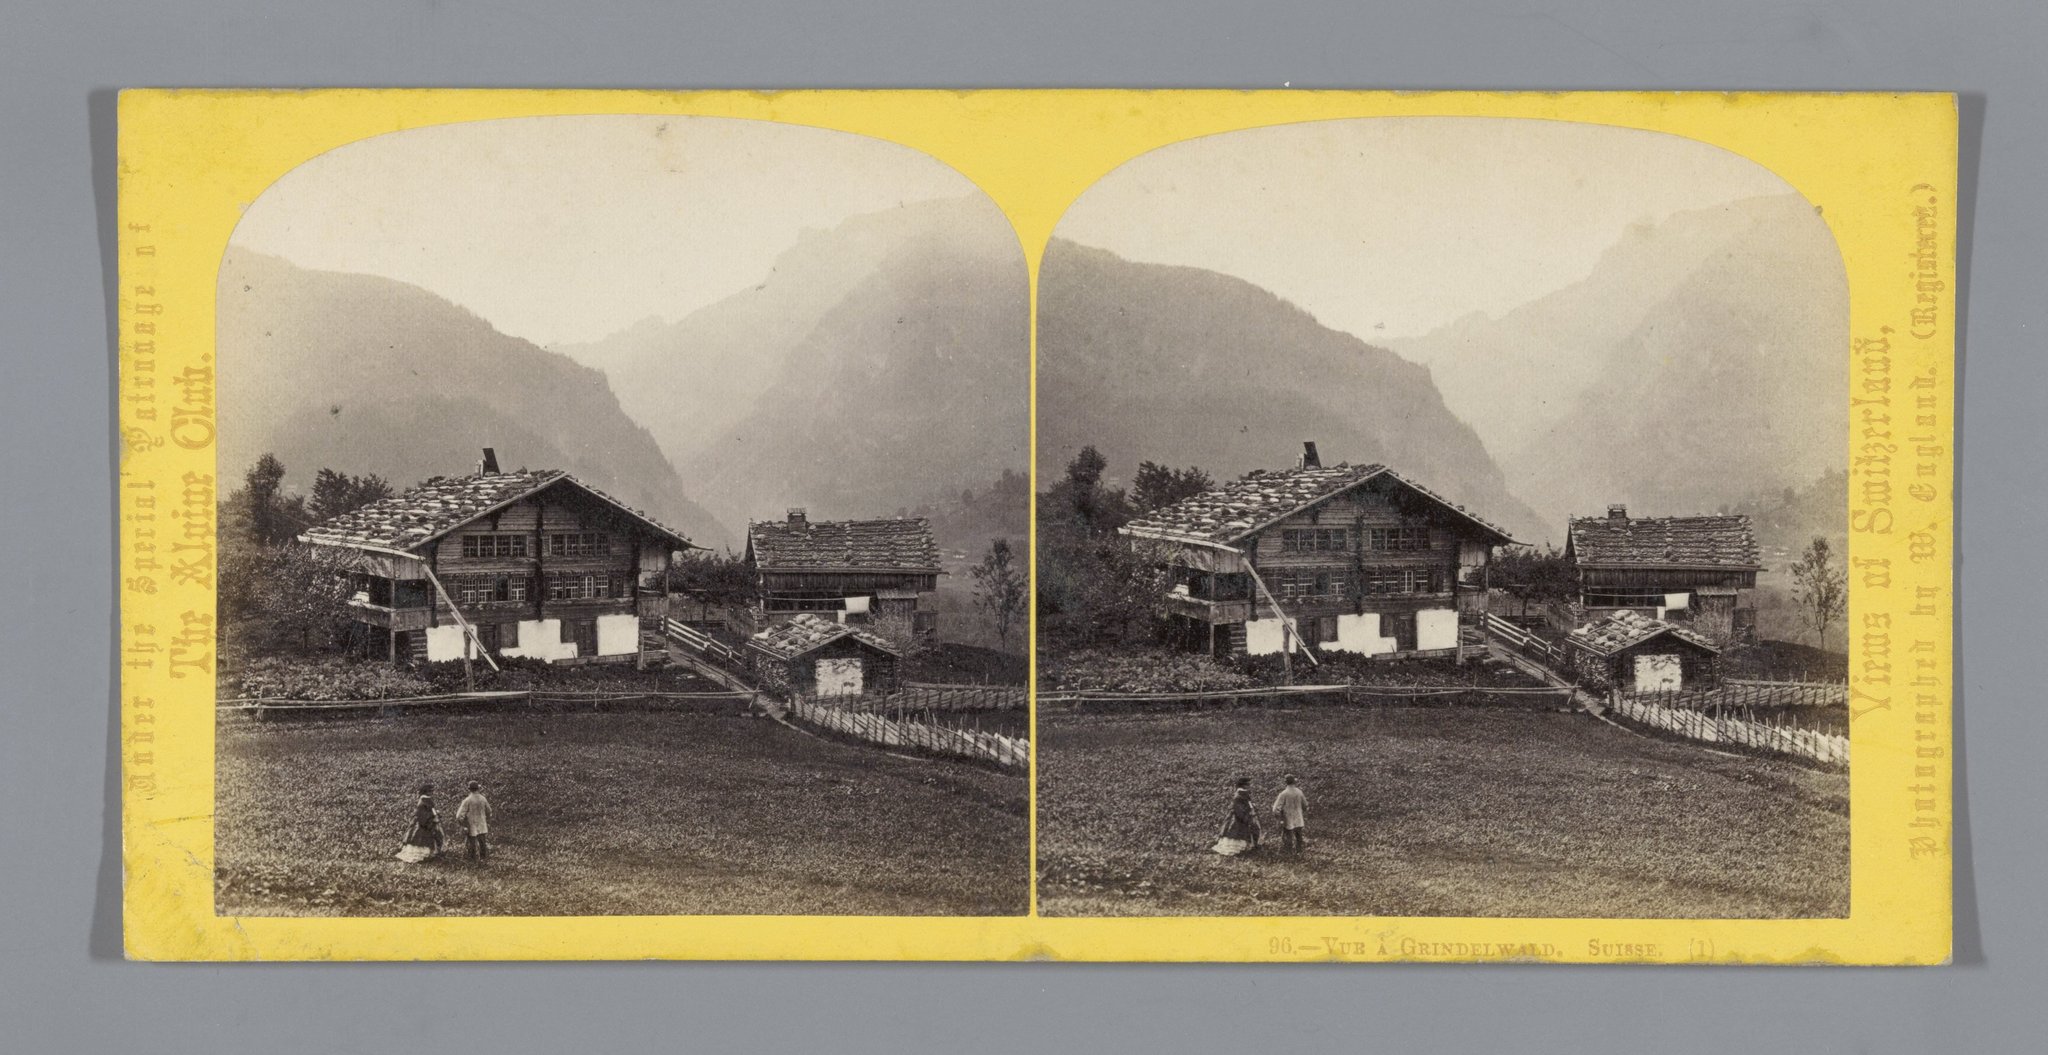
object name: stereograph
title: Vue à Grindelwald. Suisse. (1)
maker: william england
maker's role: fotograaf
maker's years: 1816-1896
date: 1850-1880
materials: cardboard, photographic support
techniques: albumen print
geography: grindelwald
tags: city-view in general; 'veduta', façade (of house or building)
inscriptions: inscription: ‘Views of Switzerland, photographed by W. England. (Registered) Under the Special Patronage of the Alpine Club.’, number: ‘96.’